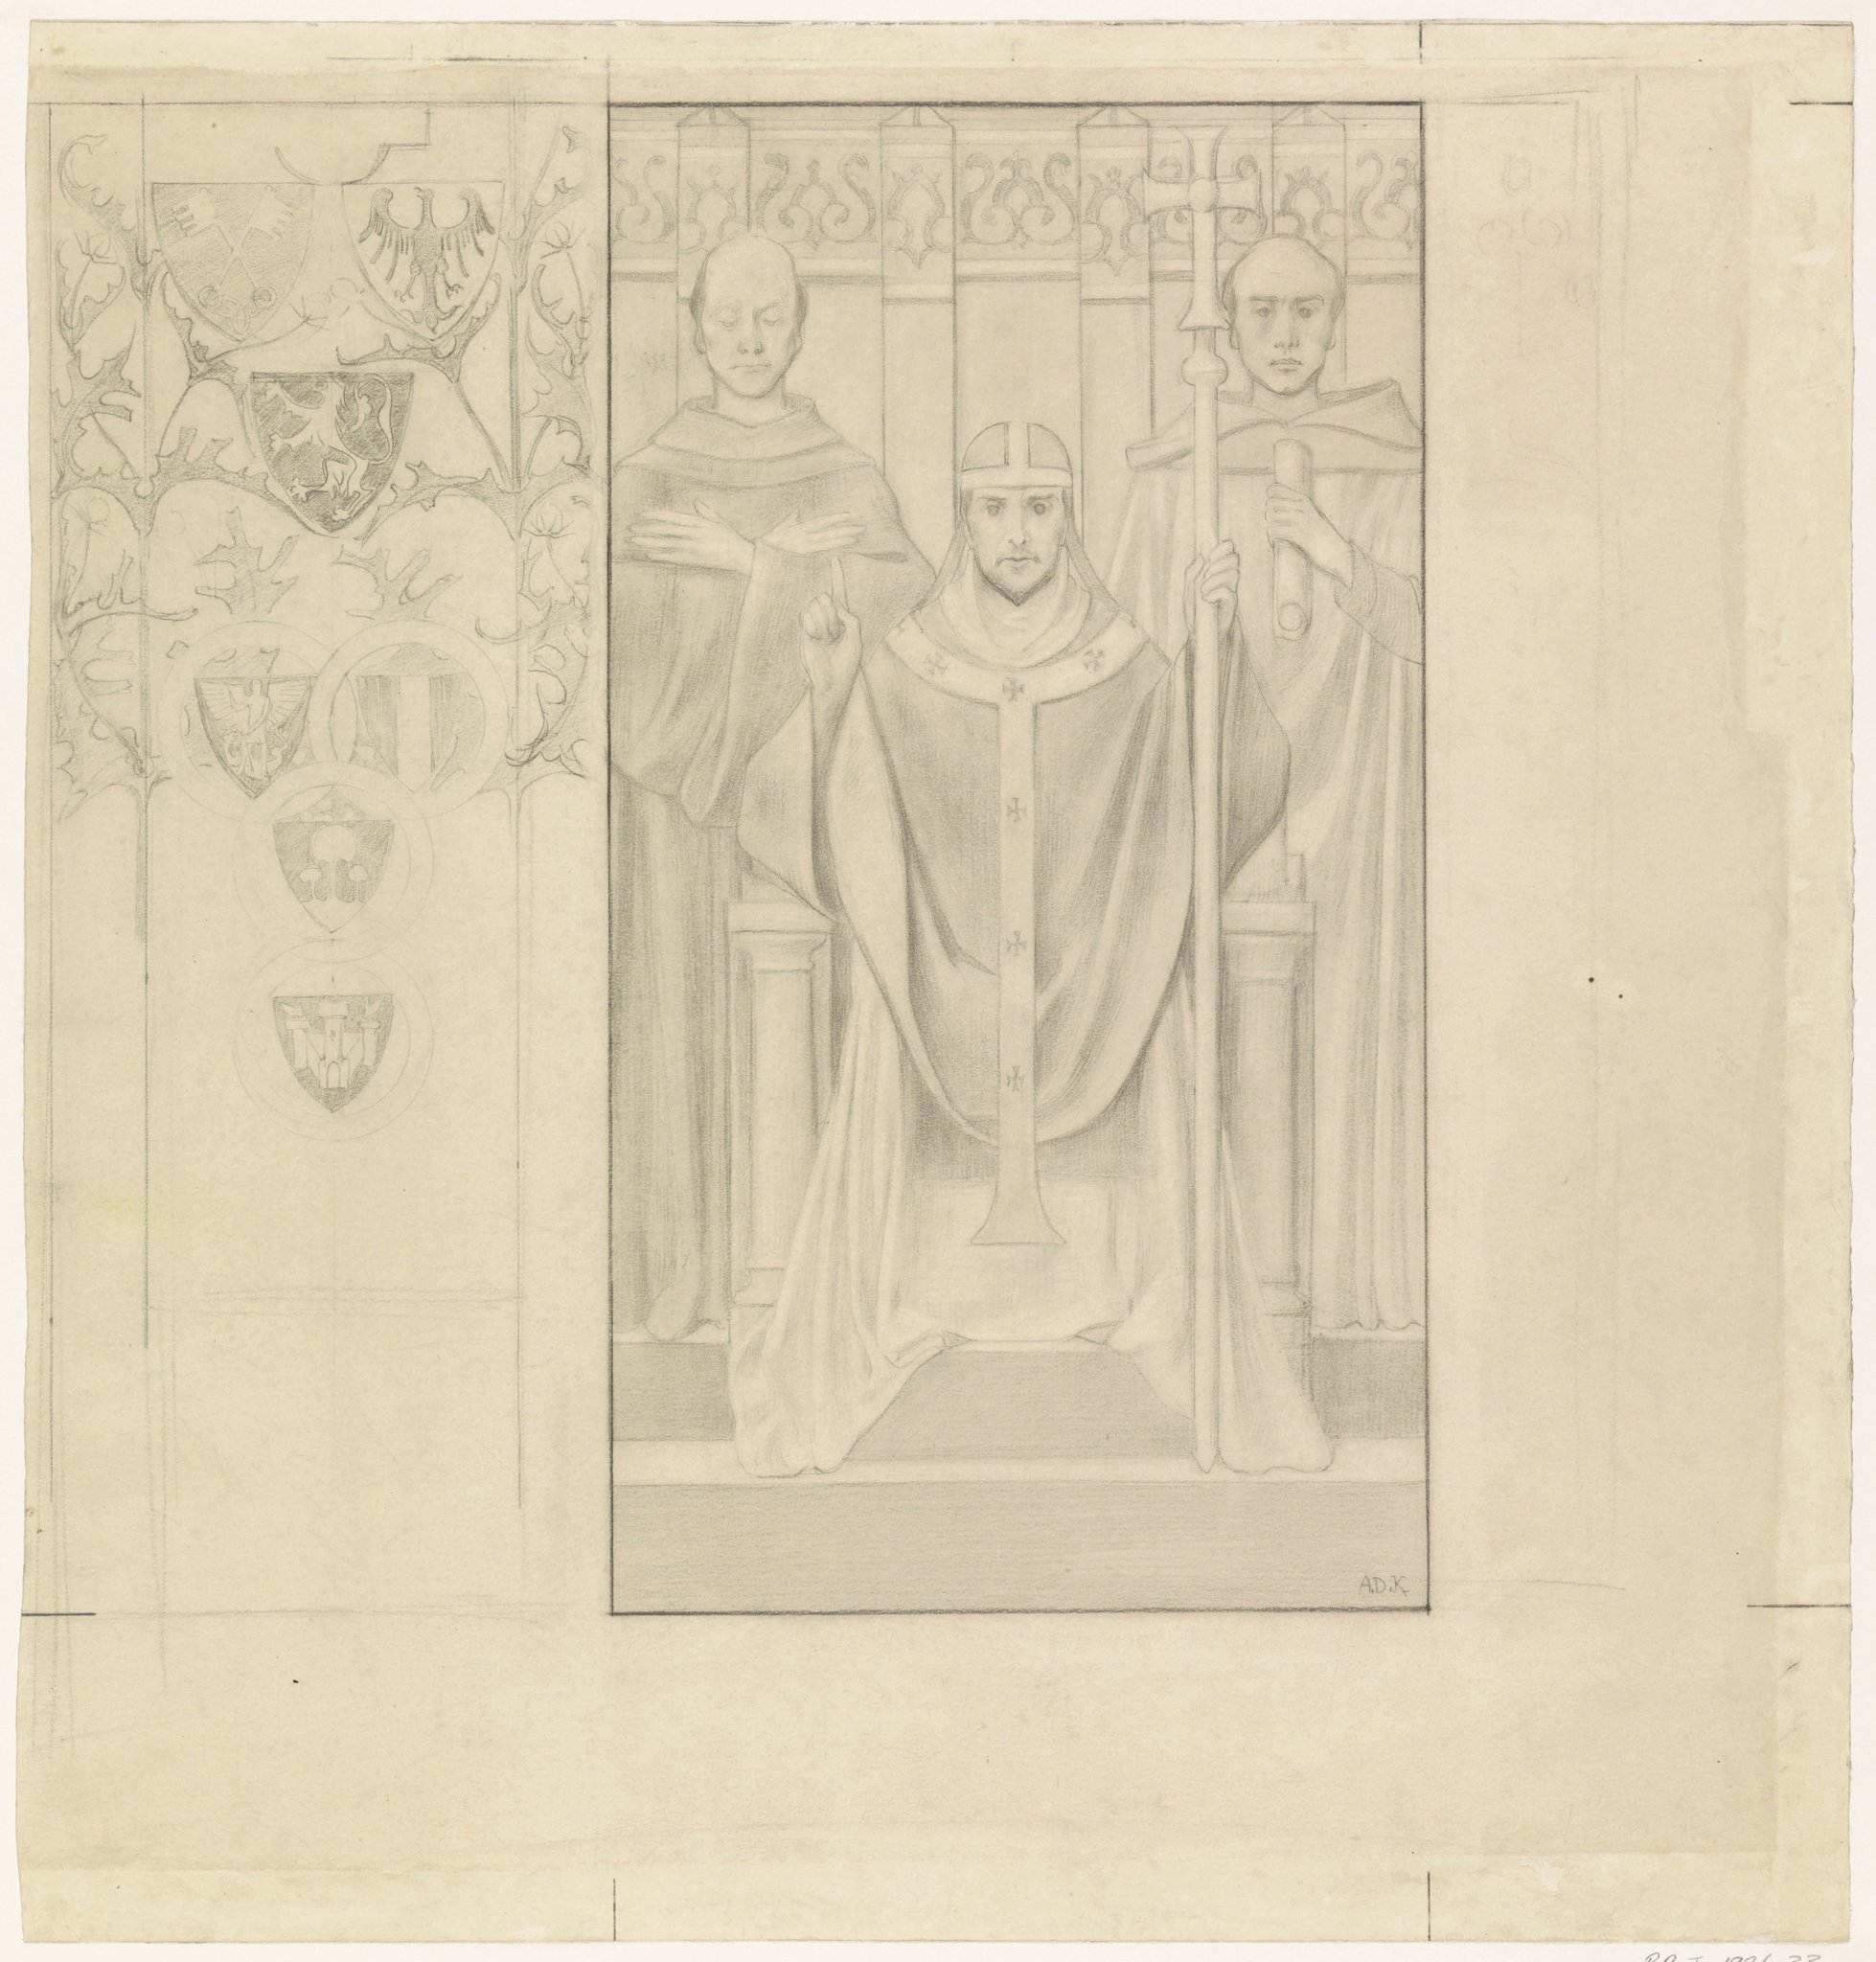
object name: design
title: Ontwerp voor de Eerste Bossche Wand: De Paus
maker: antoon derkinderen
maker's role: draughtsman, painter, print maker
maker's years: 1859-1925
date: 1869-1925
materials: chalk, paper, pencil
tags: coat of arms (as symbol of the state, etc.), pope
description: De tekening betreft een ontwerp voor een wandschildering.